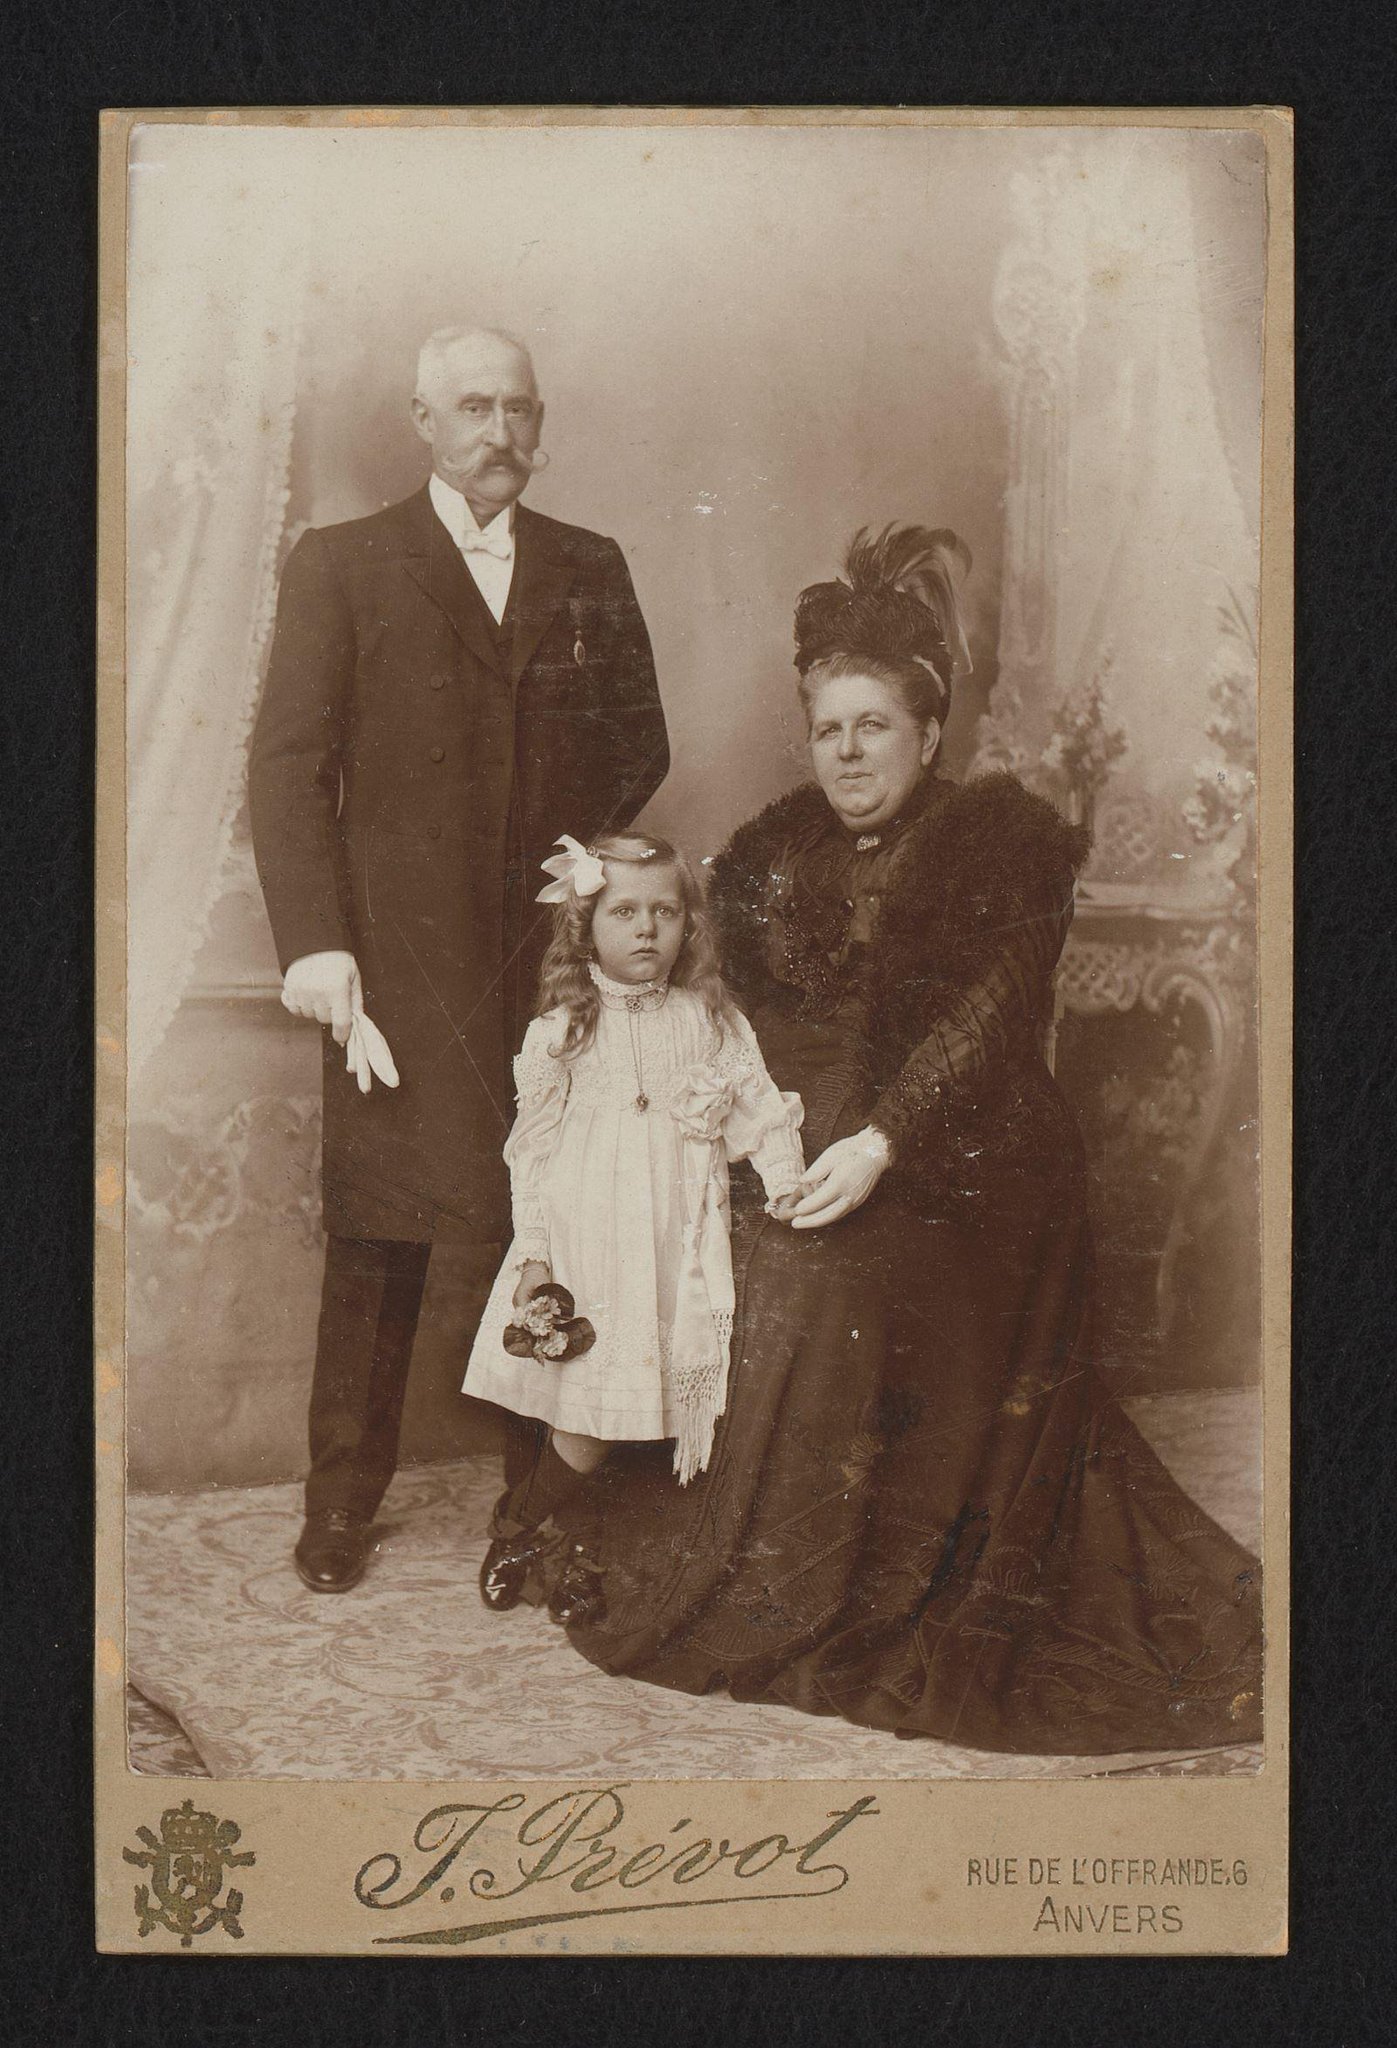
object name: album leaf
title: Groepsportret van een man, vrouw en meisje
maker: jacques prévot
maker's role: fotograaf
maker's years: 1857-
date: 1897-1918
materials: paper, cardboard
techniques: collodion silver print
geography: antwerp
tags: family group, especially parents with their child(ren), anonymous historical person portrayed, child(ren) with one or both parents and one or more members of the preceding generation (family group), antwerp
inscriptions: inscription: ‘Photographie/ J. Prévot/ 6, Rue de l'Offrande, 6/ Coin de la rue Dambrugge/ (bien remarquer l'adresse)/ Anvers/ Les clichés sont conservés’, inscription: ‘J. Prévot/ Rue de l'Offrande, 6/ Anvers’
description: Over de foto is een ander negatief afgedrukt van een voorstelling van bomen.